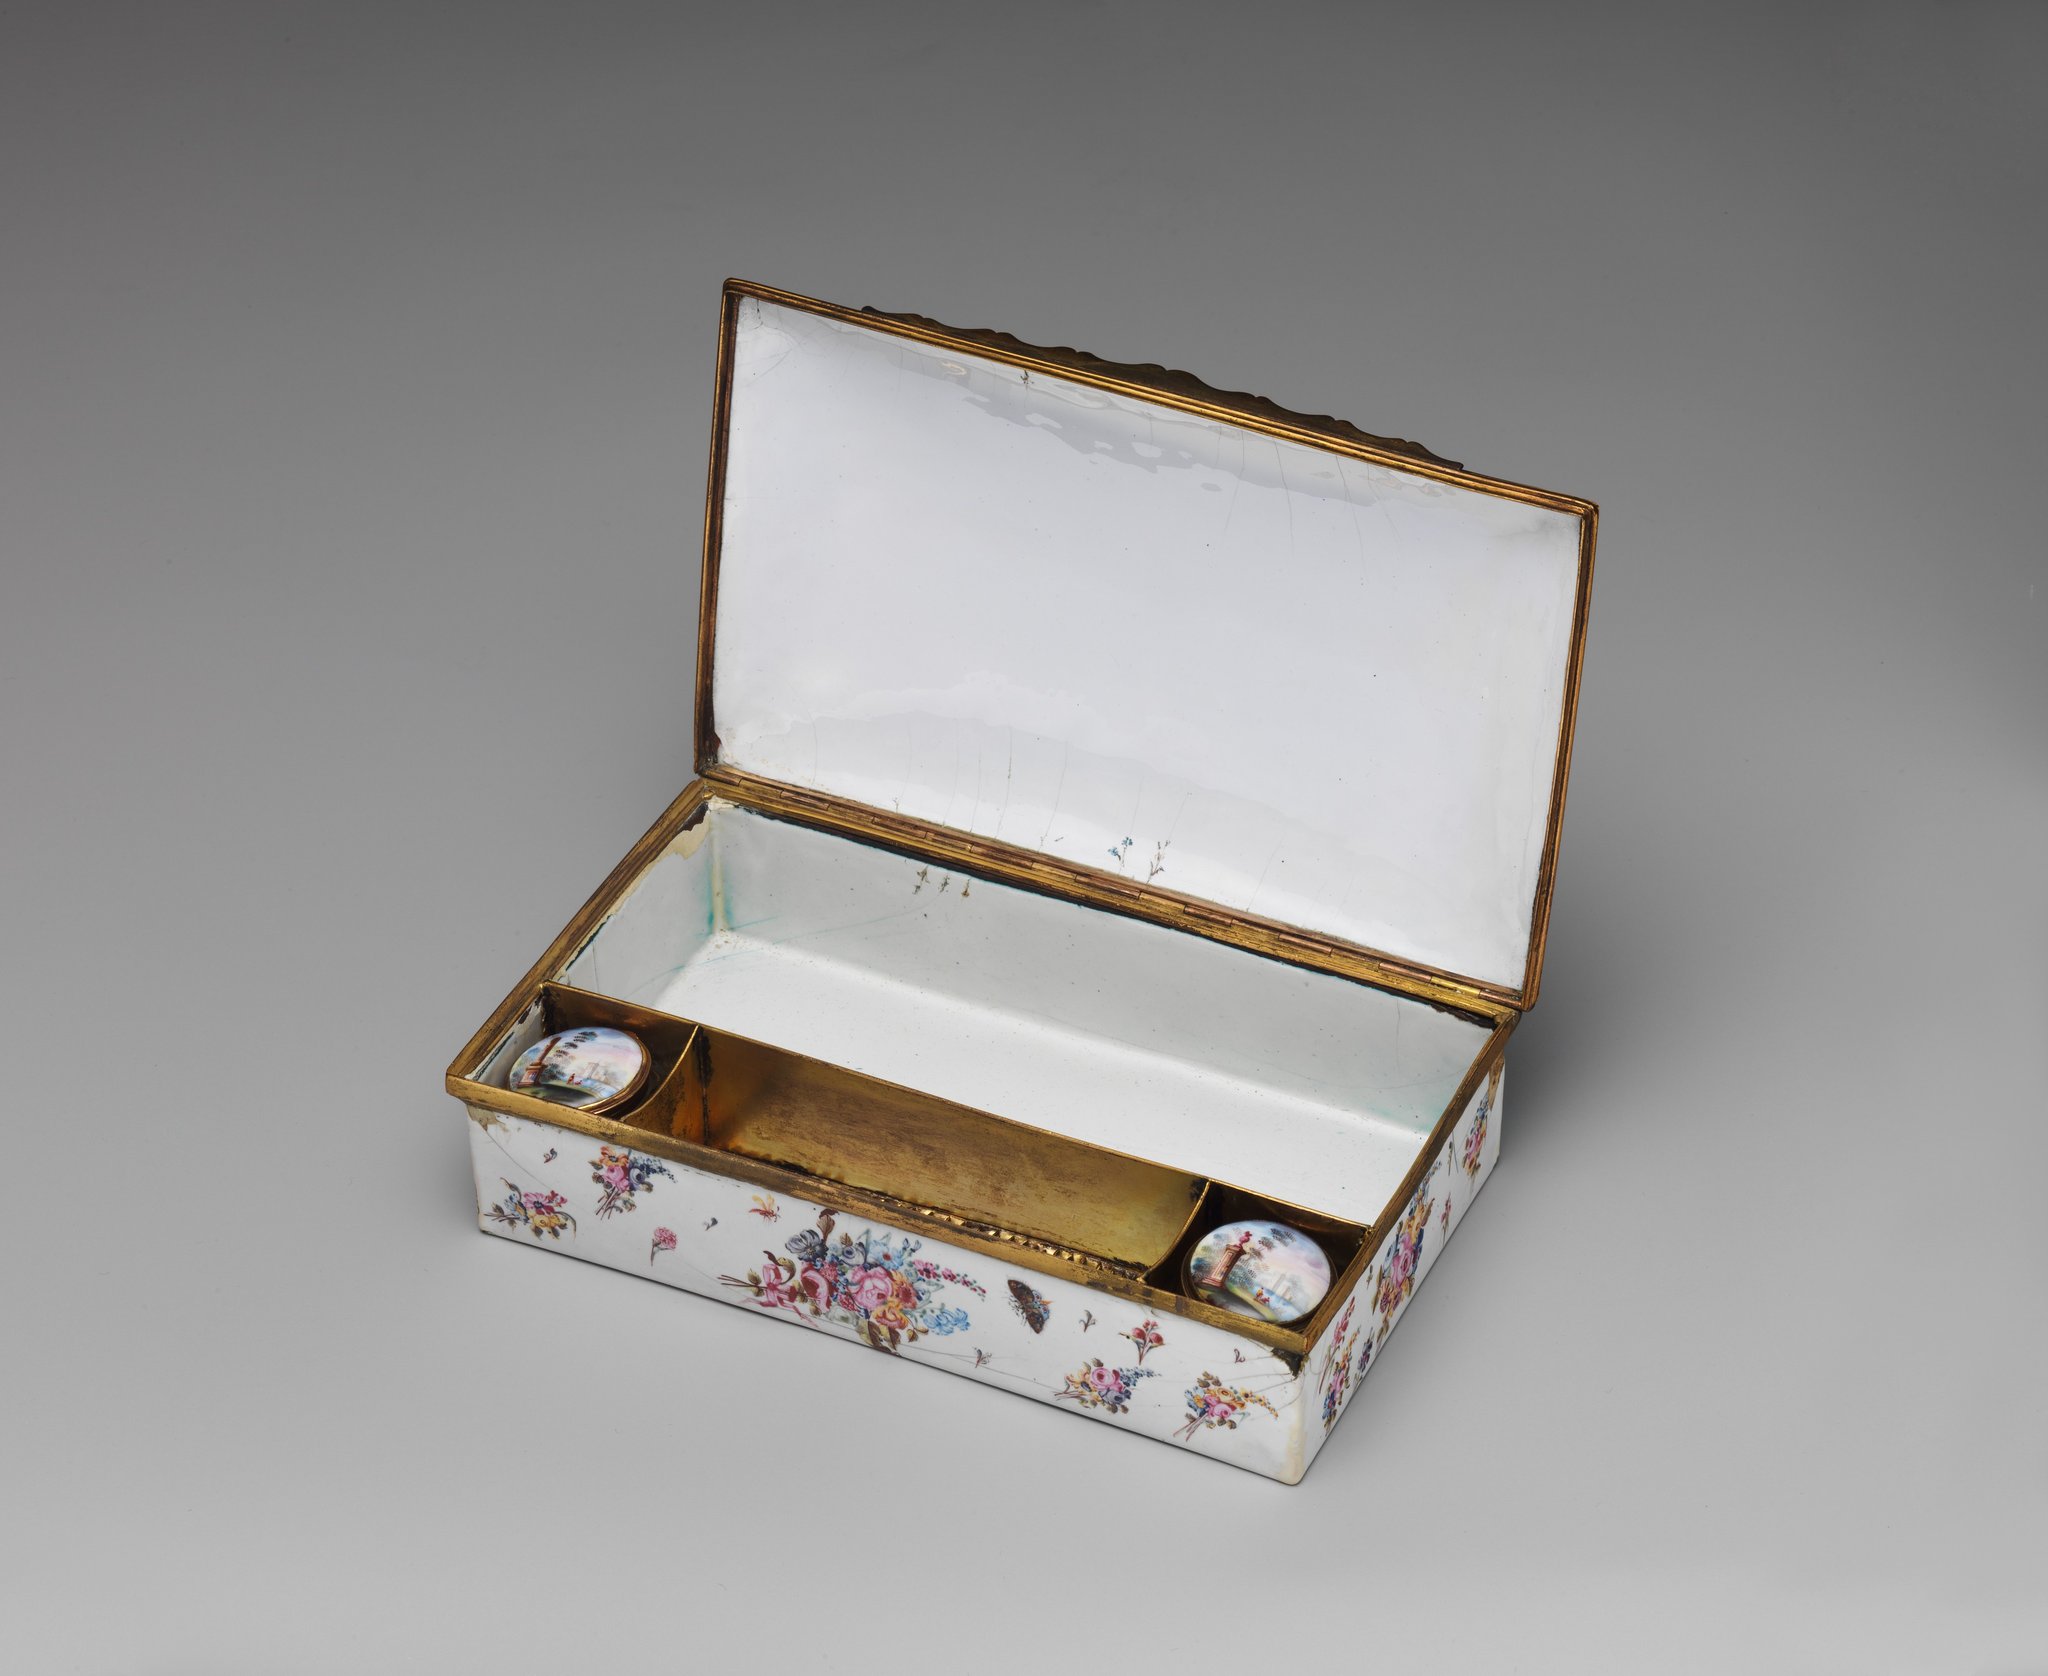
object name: inkwell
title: Inkwell (part of a set)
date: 1750-1760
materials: copper, copper gilt, glass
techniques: enamel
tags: men,butterflies,flowers